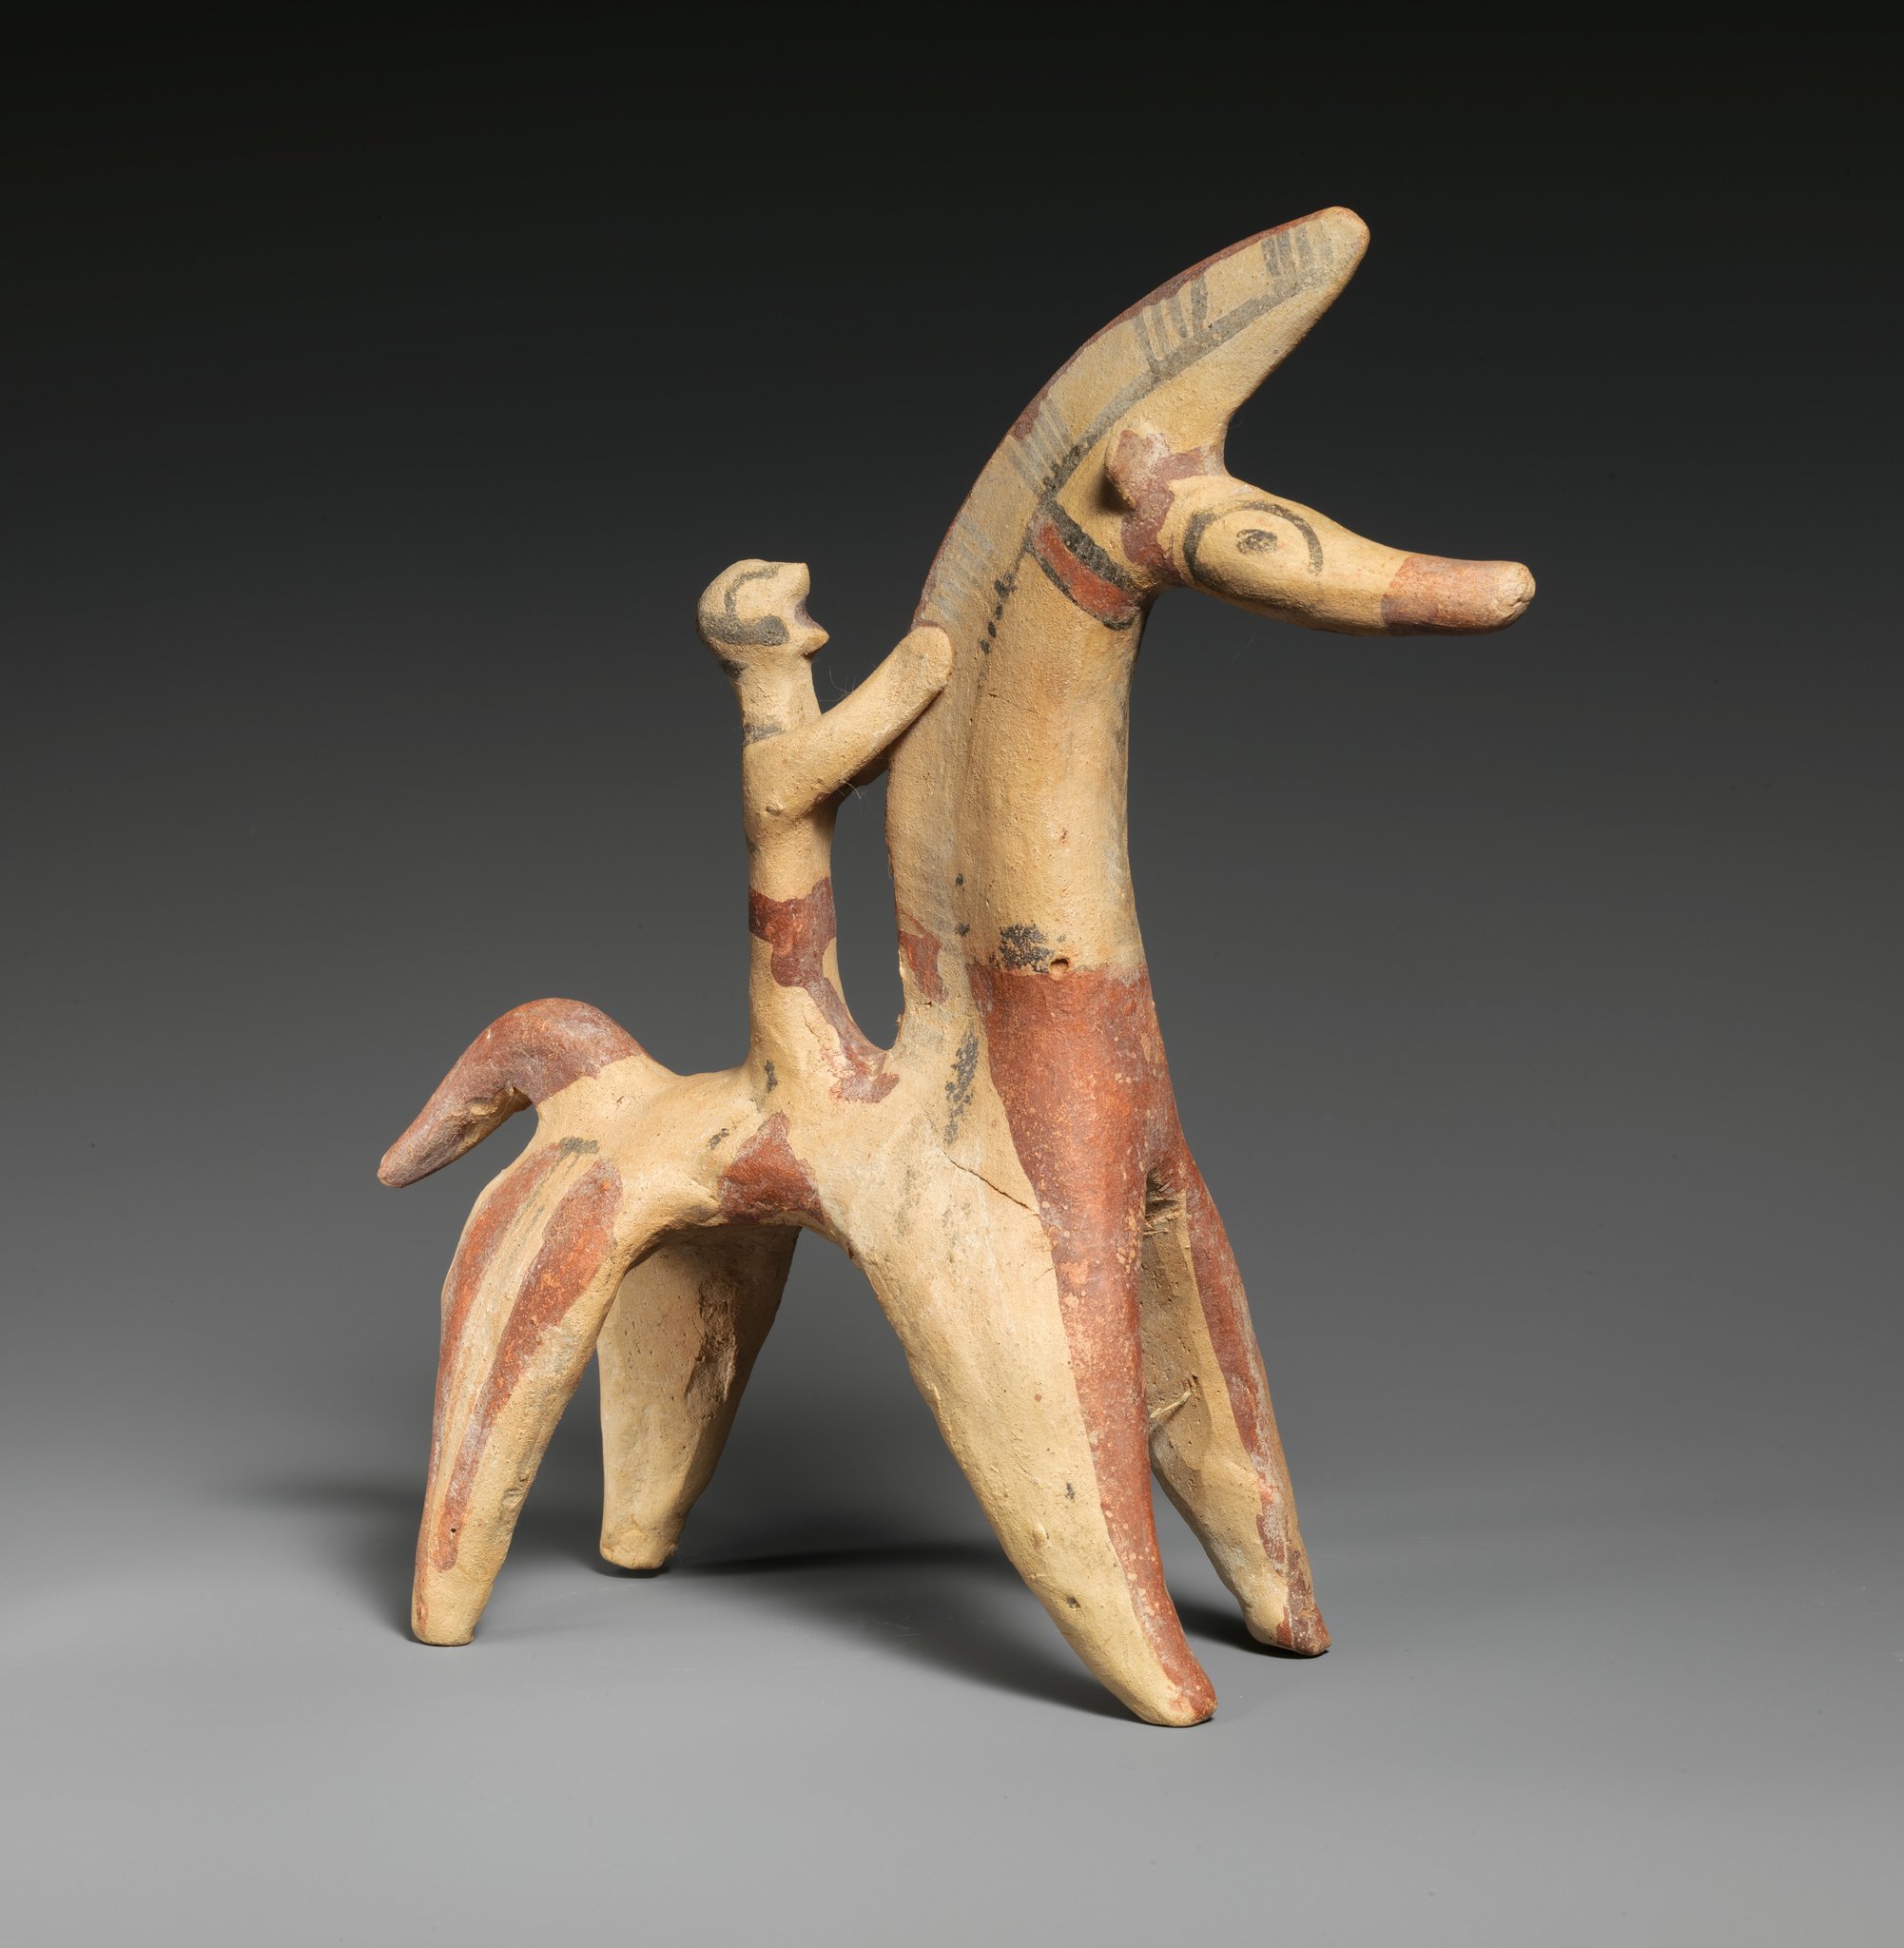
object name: statuette of a horse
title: Terracotta horse and rider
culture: cypriot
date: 750-600 BCE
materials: terracotta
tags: human figures,horses